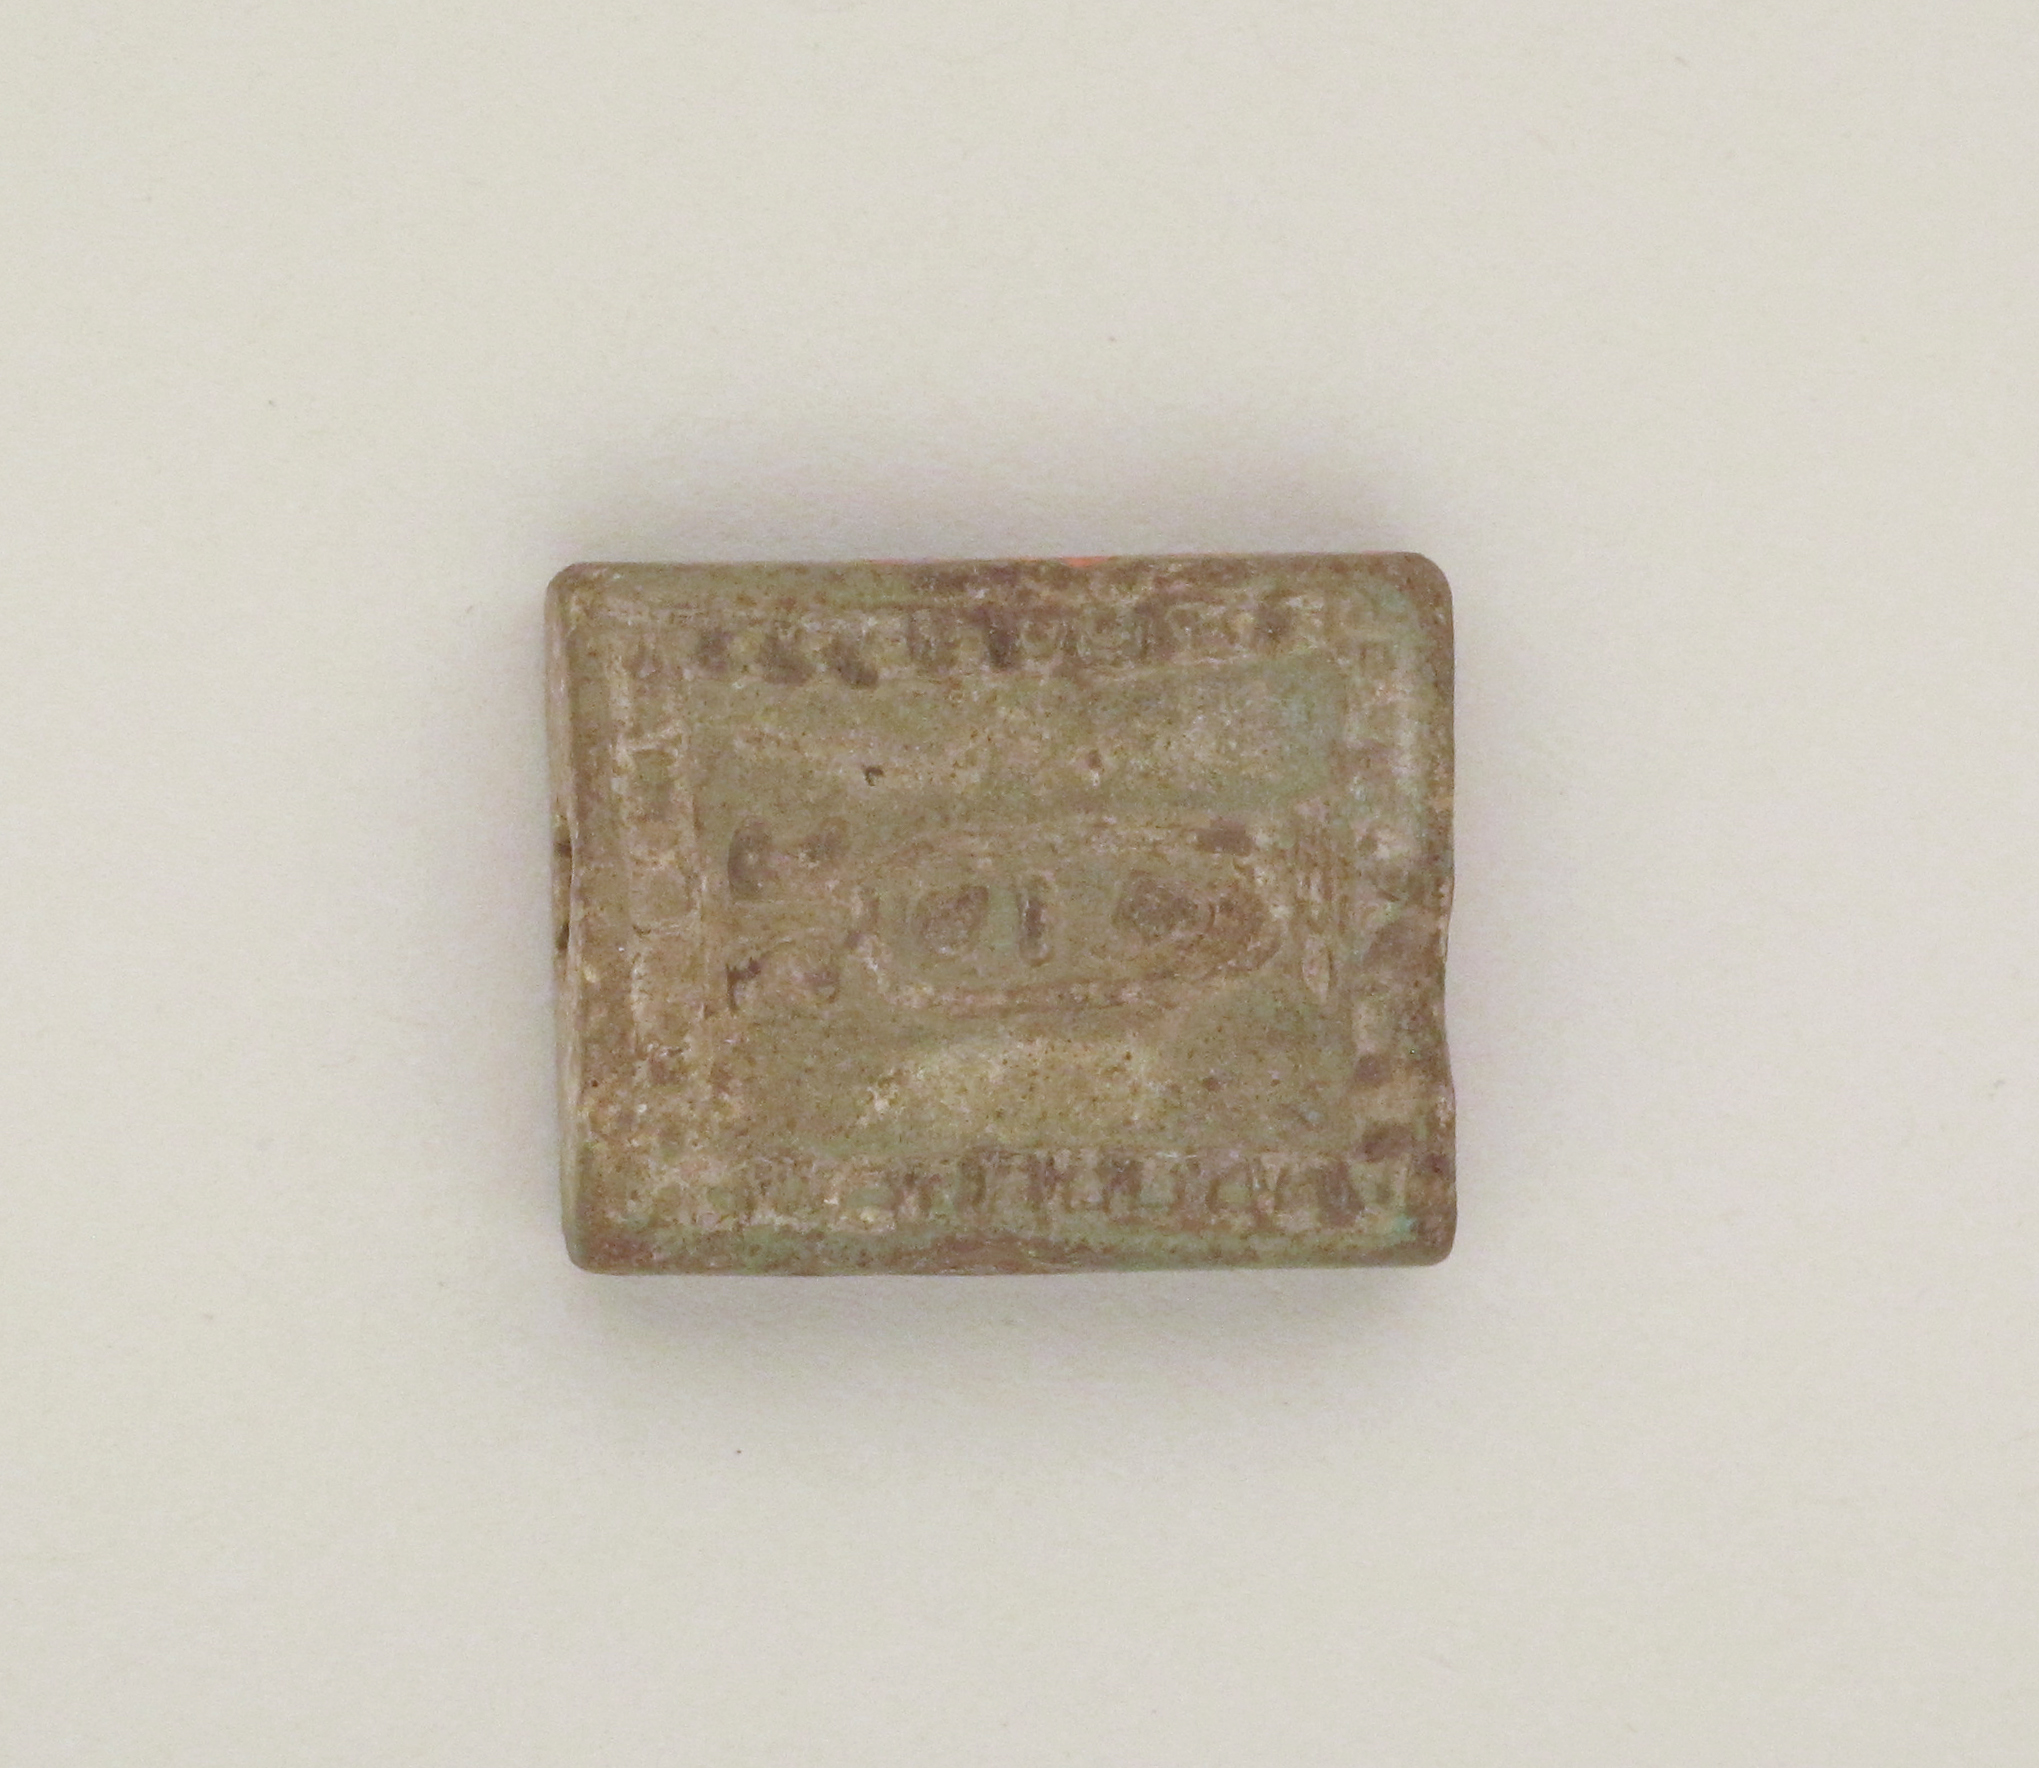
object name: amulet plaque inscribed men kheper ra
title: Faience amulet plaque inscribed "Men-Kheper-ra"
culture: egyptian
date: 1050-900 BCE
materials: faience